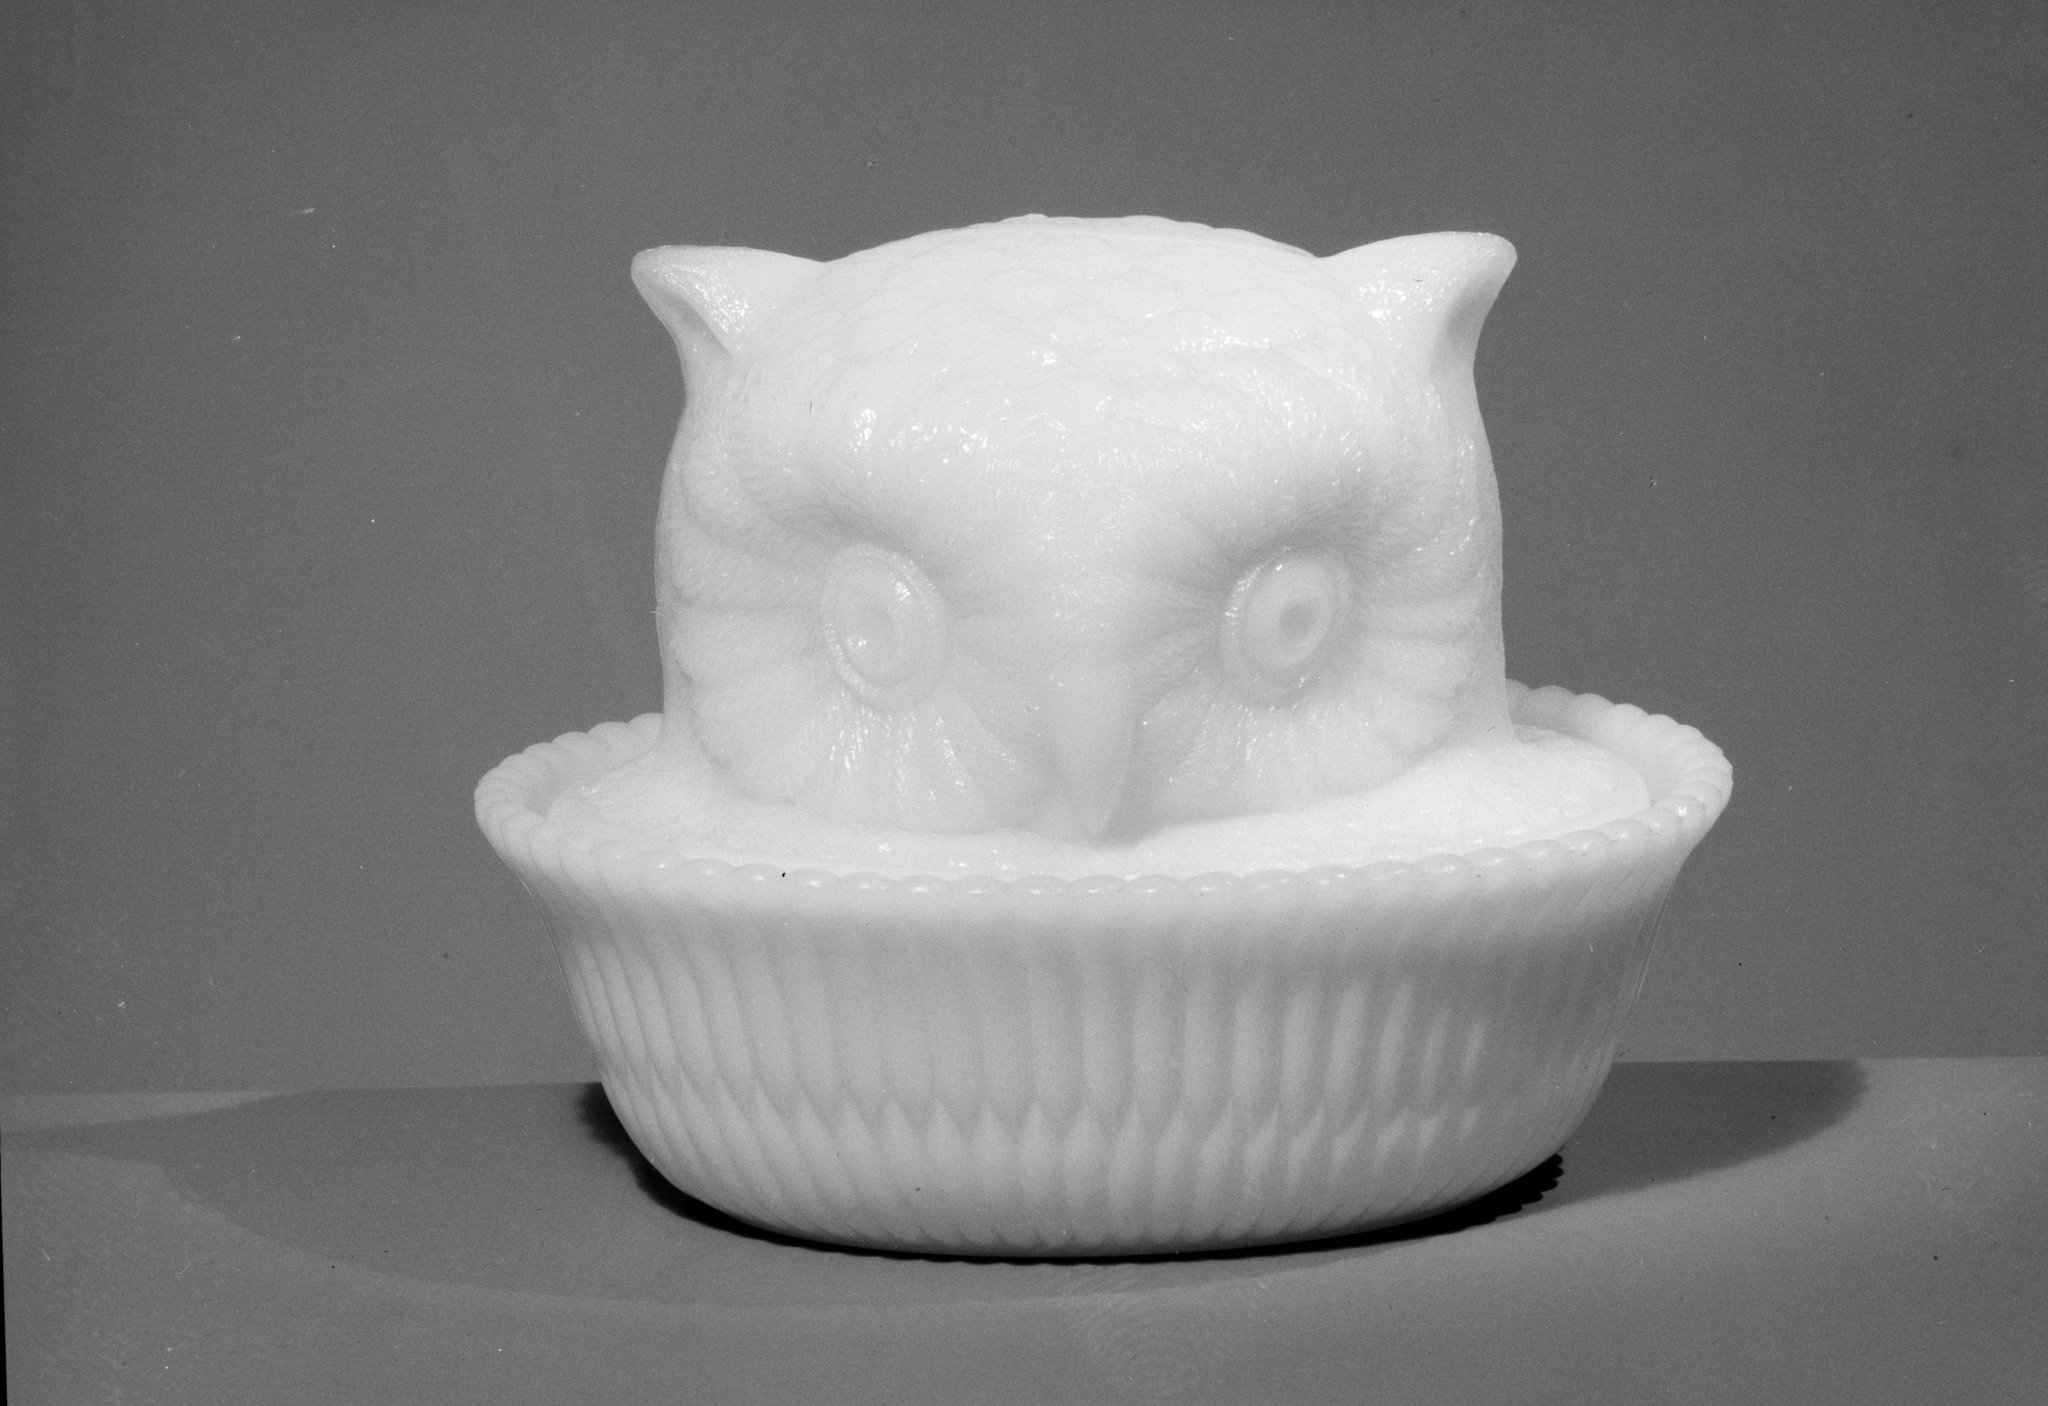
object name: dish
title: Figure Dish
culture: american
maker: mckee and brothers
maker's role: maker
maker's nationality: american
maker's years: 1856-1889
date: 1880-1890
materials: glass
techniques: pressed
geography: united states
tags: owls